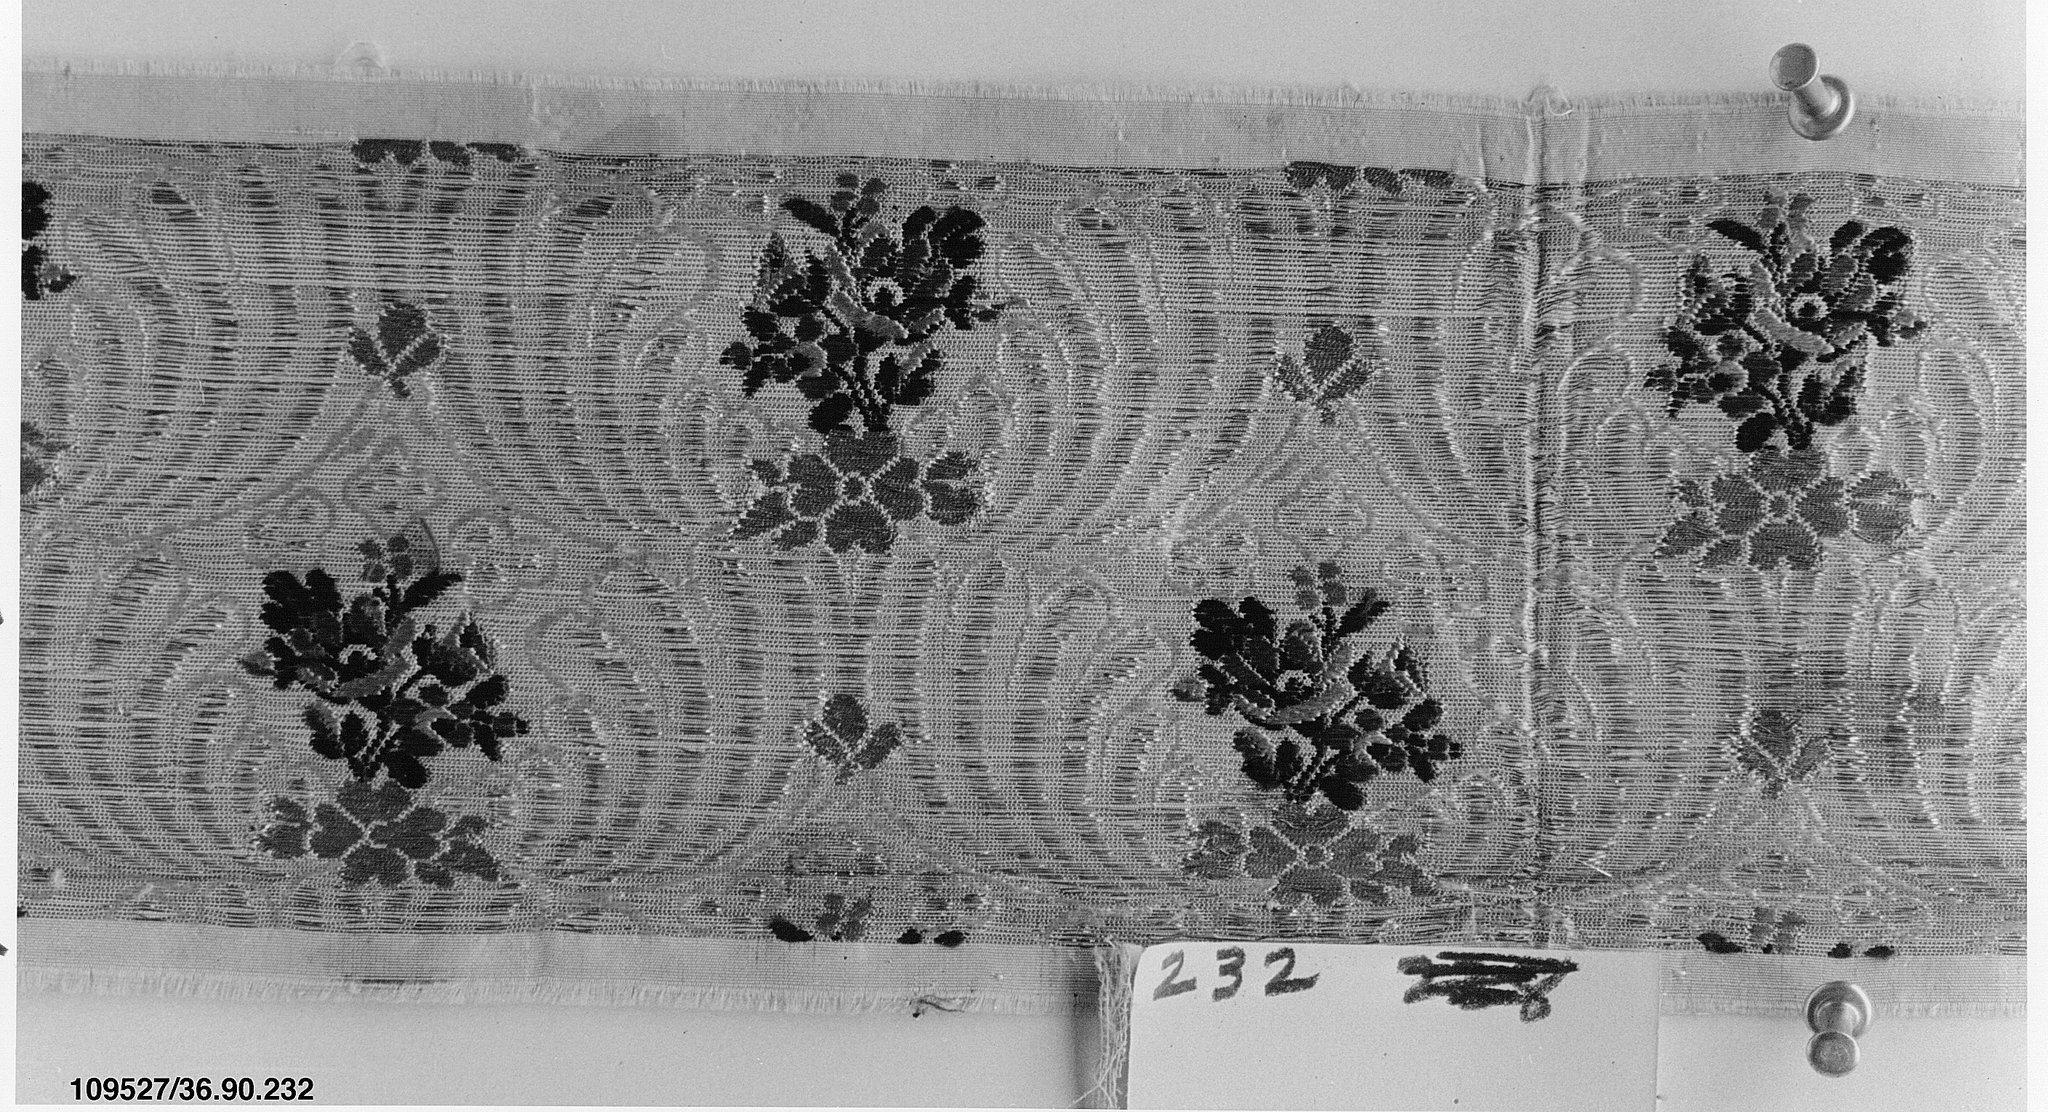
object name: piece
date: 1770-1780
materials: metal thread, silk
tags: flowers,leaves